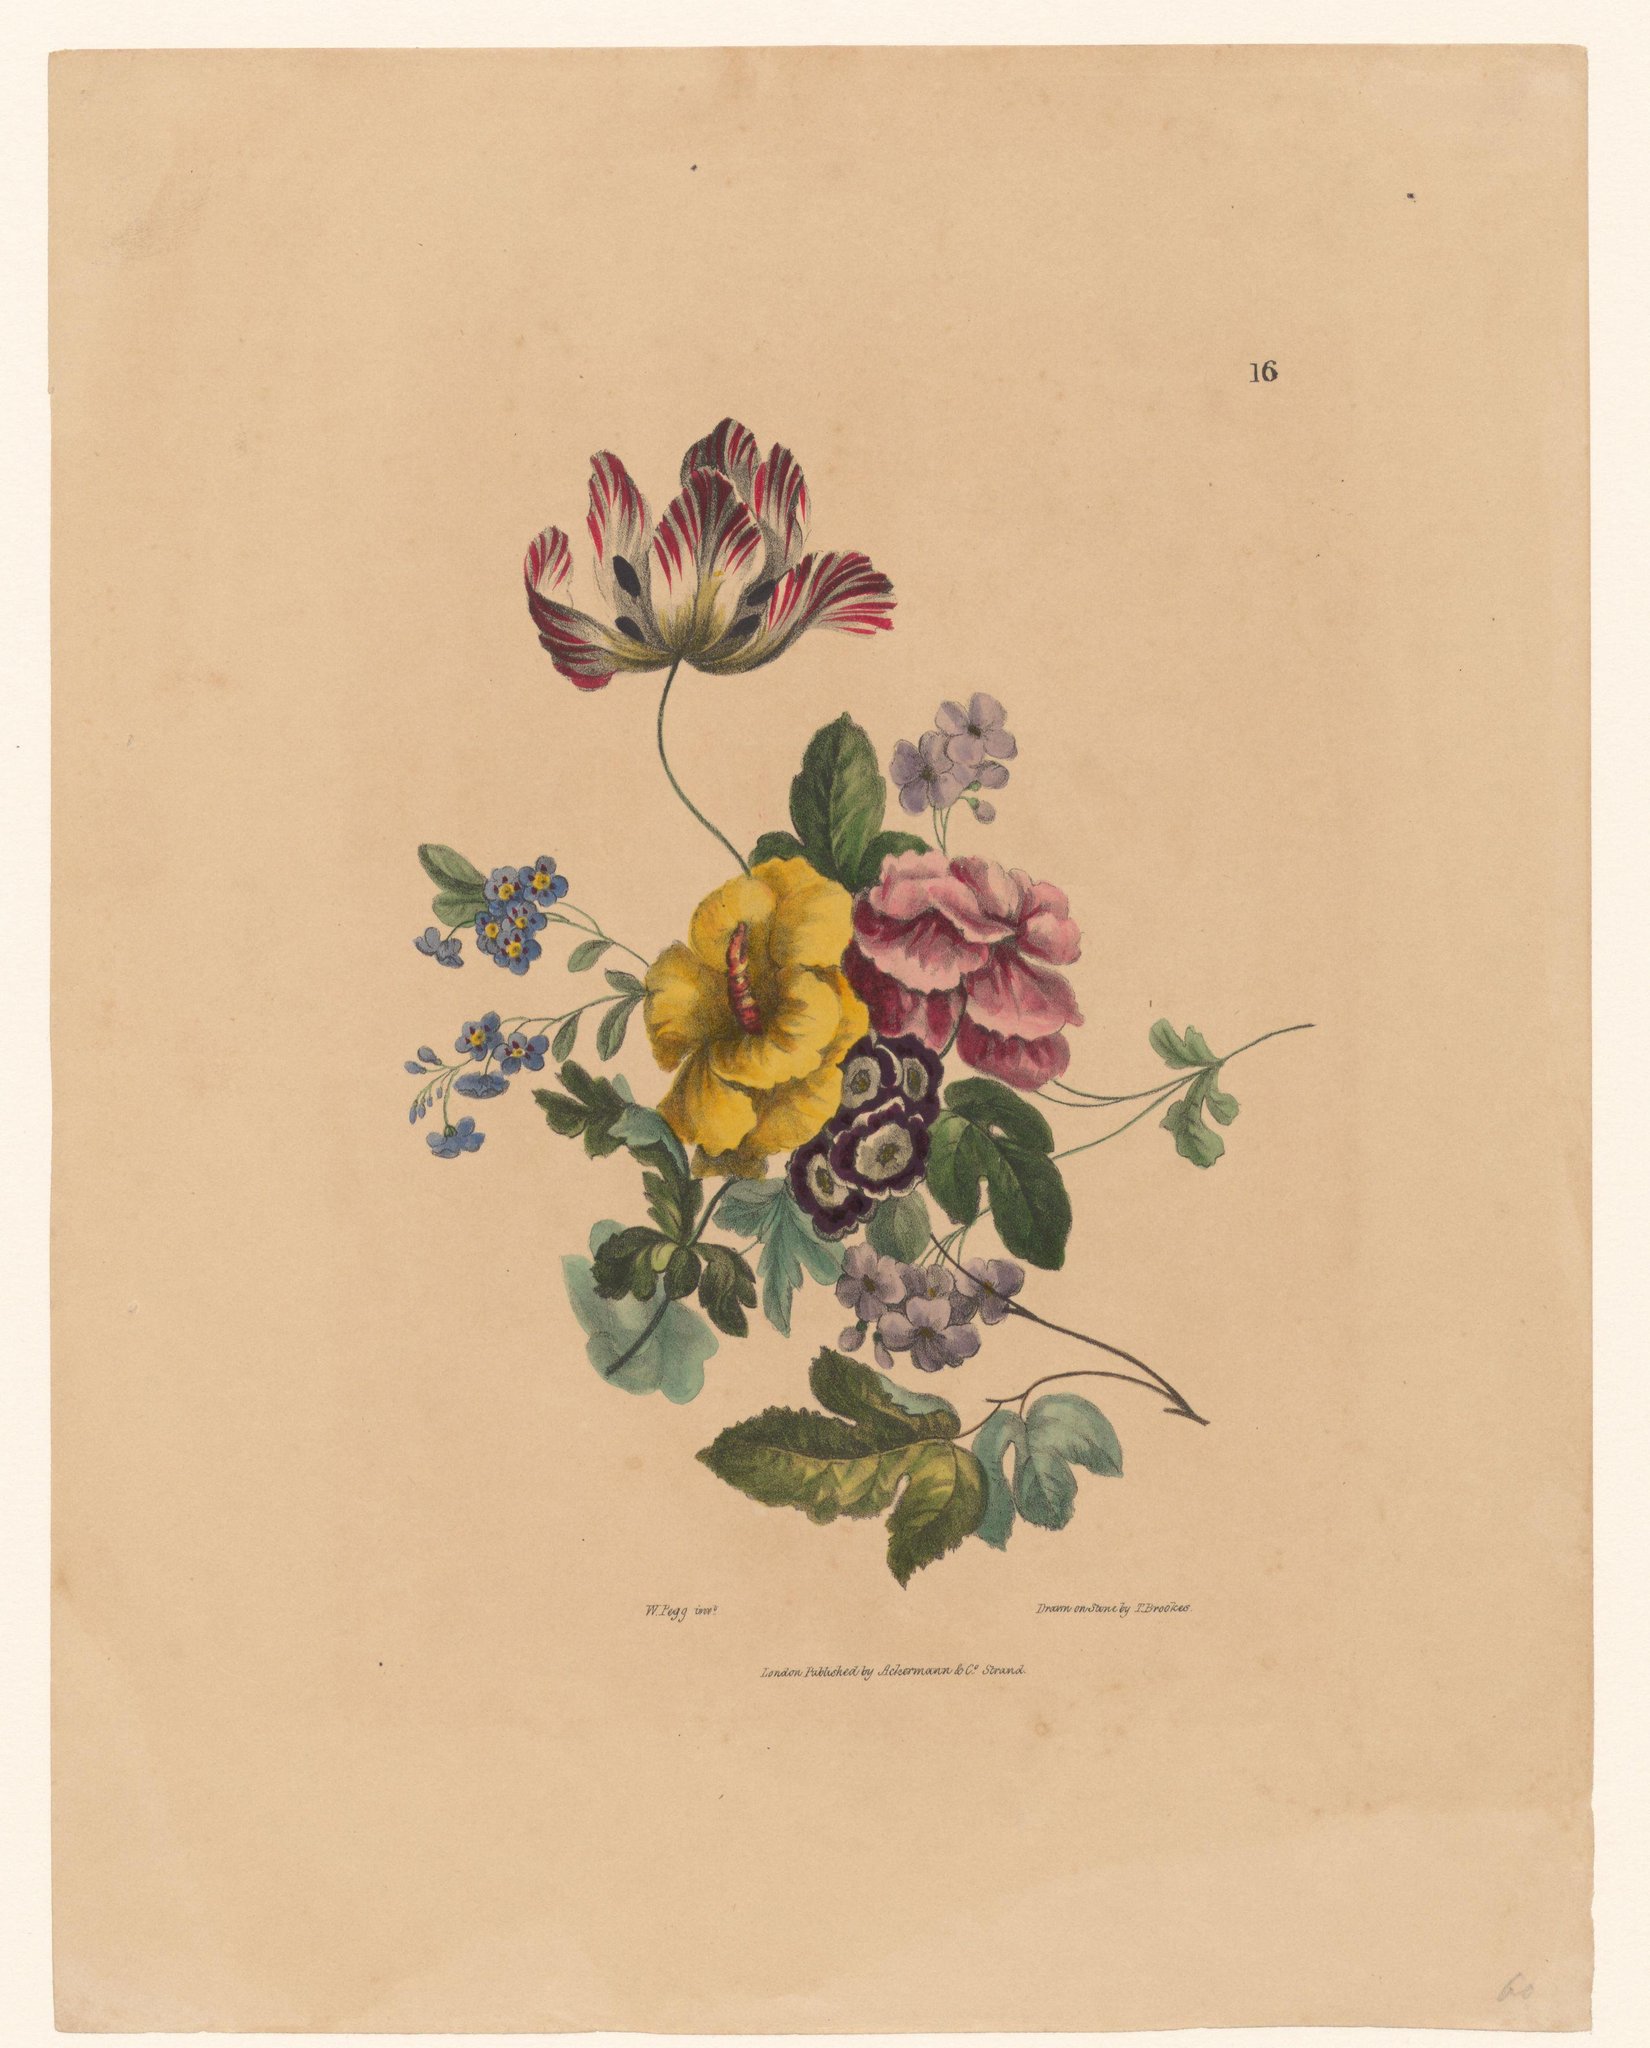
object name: print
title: Bloemen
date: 1820-1840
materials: paper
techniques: hand coloring, lithograph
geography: london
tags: flowers, flowers: tulip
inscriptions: collector's mark: Lugt 2228